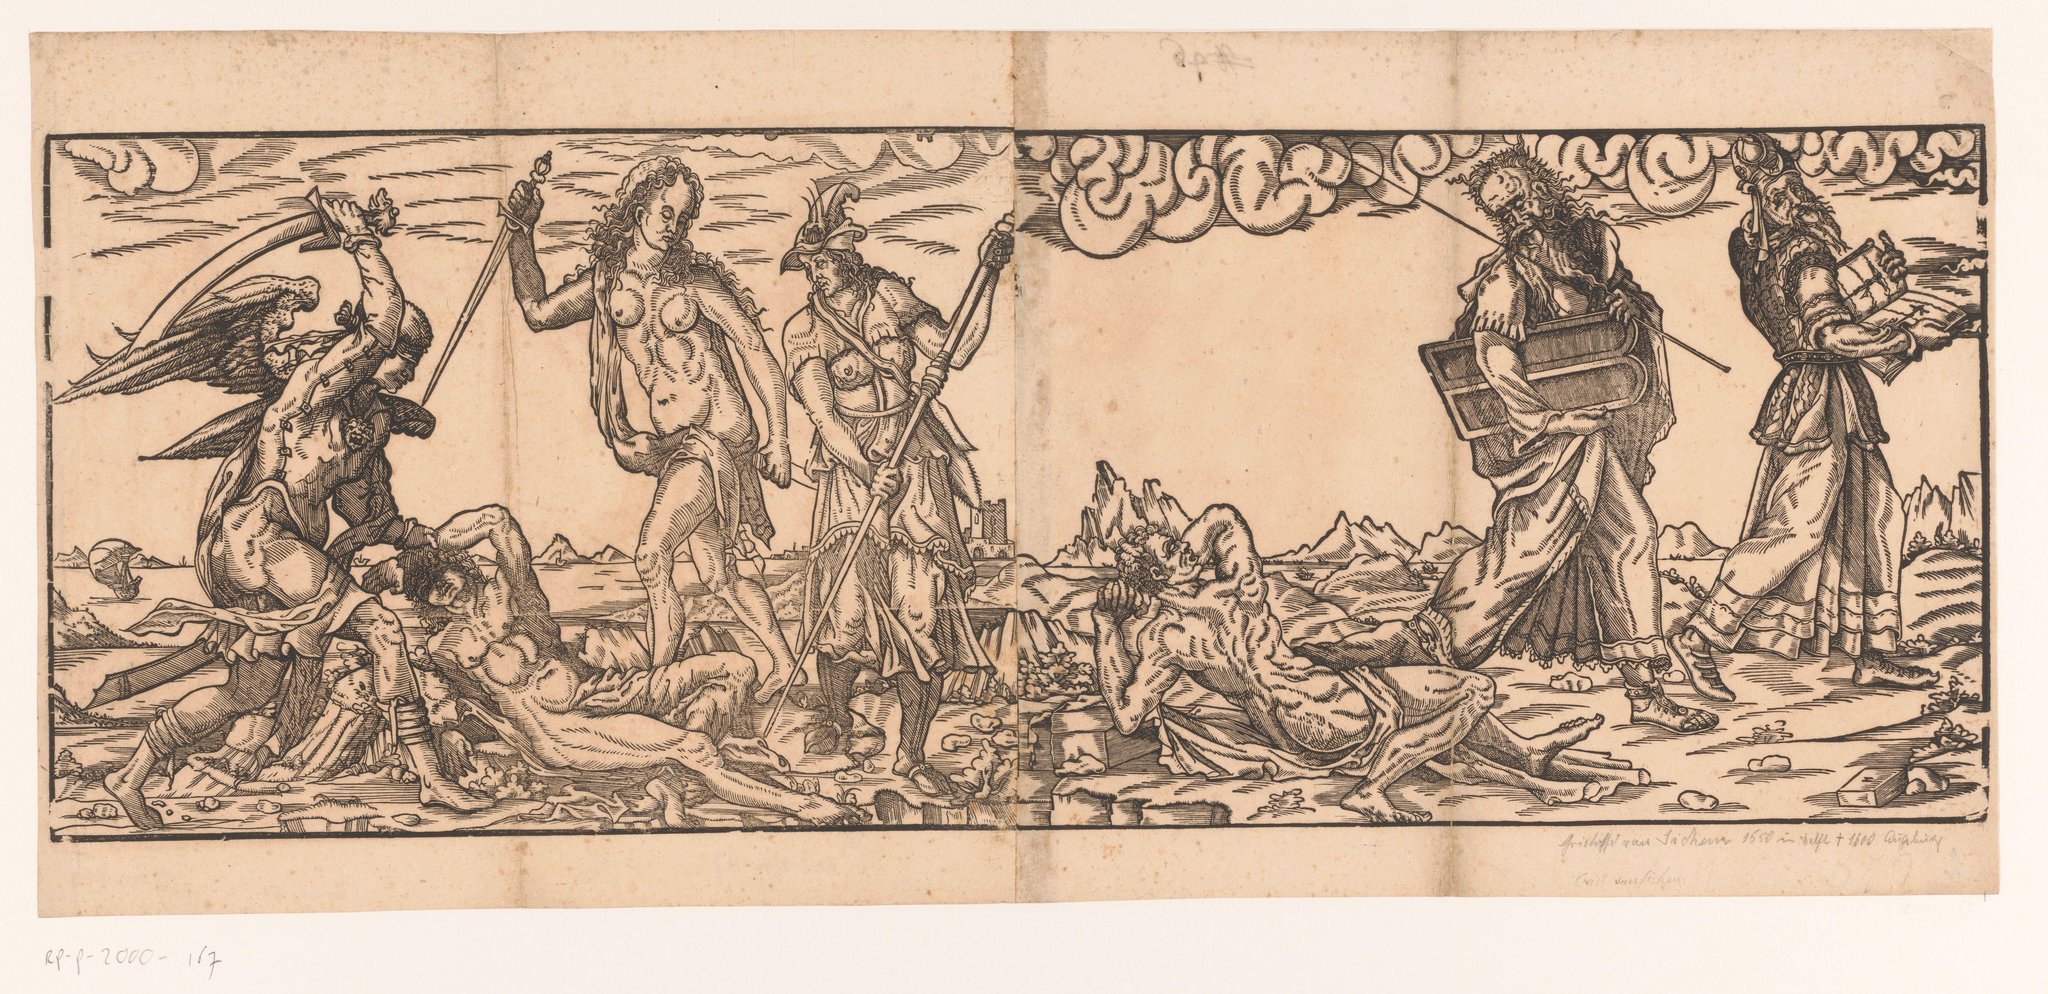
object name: print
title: Allegorie met motief van de Barmhartige Samaritaan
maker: martin weigel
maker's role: print maker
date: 1550-1580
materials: paper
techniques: woodcut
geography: germany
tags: abstract ideas and concepts (+ allegorical scene, i.e. two or more personifications involved in an action), the good samaritan (luke 10:30-37), the book exodus: story of moses and aaron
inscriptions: collector's mark: Lugt 2228, collector's mark: Lugt 4266, collector's mark: Lugt 2760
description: Op de grond liggen twee naakte mannelijke figuren. De linker wordt aangevallen door een gevleugelde geblinddoekte mannenfiguur, die een zwaard opheft en een naakte vrouw met zwaard. Een ridderfiguur met lans staat erbij te kijken. De tweede naakte man op de grond wordt voorbijgelopen door Mozes en Aaron.